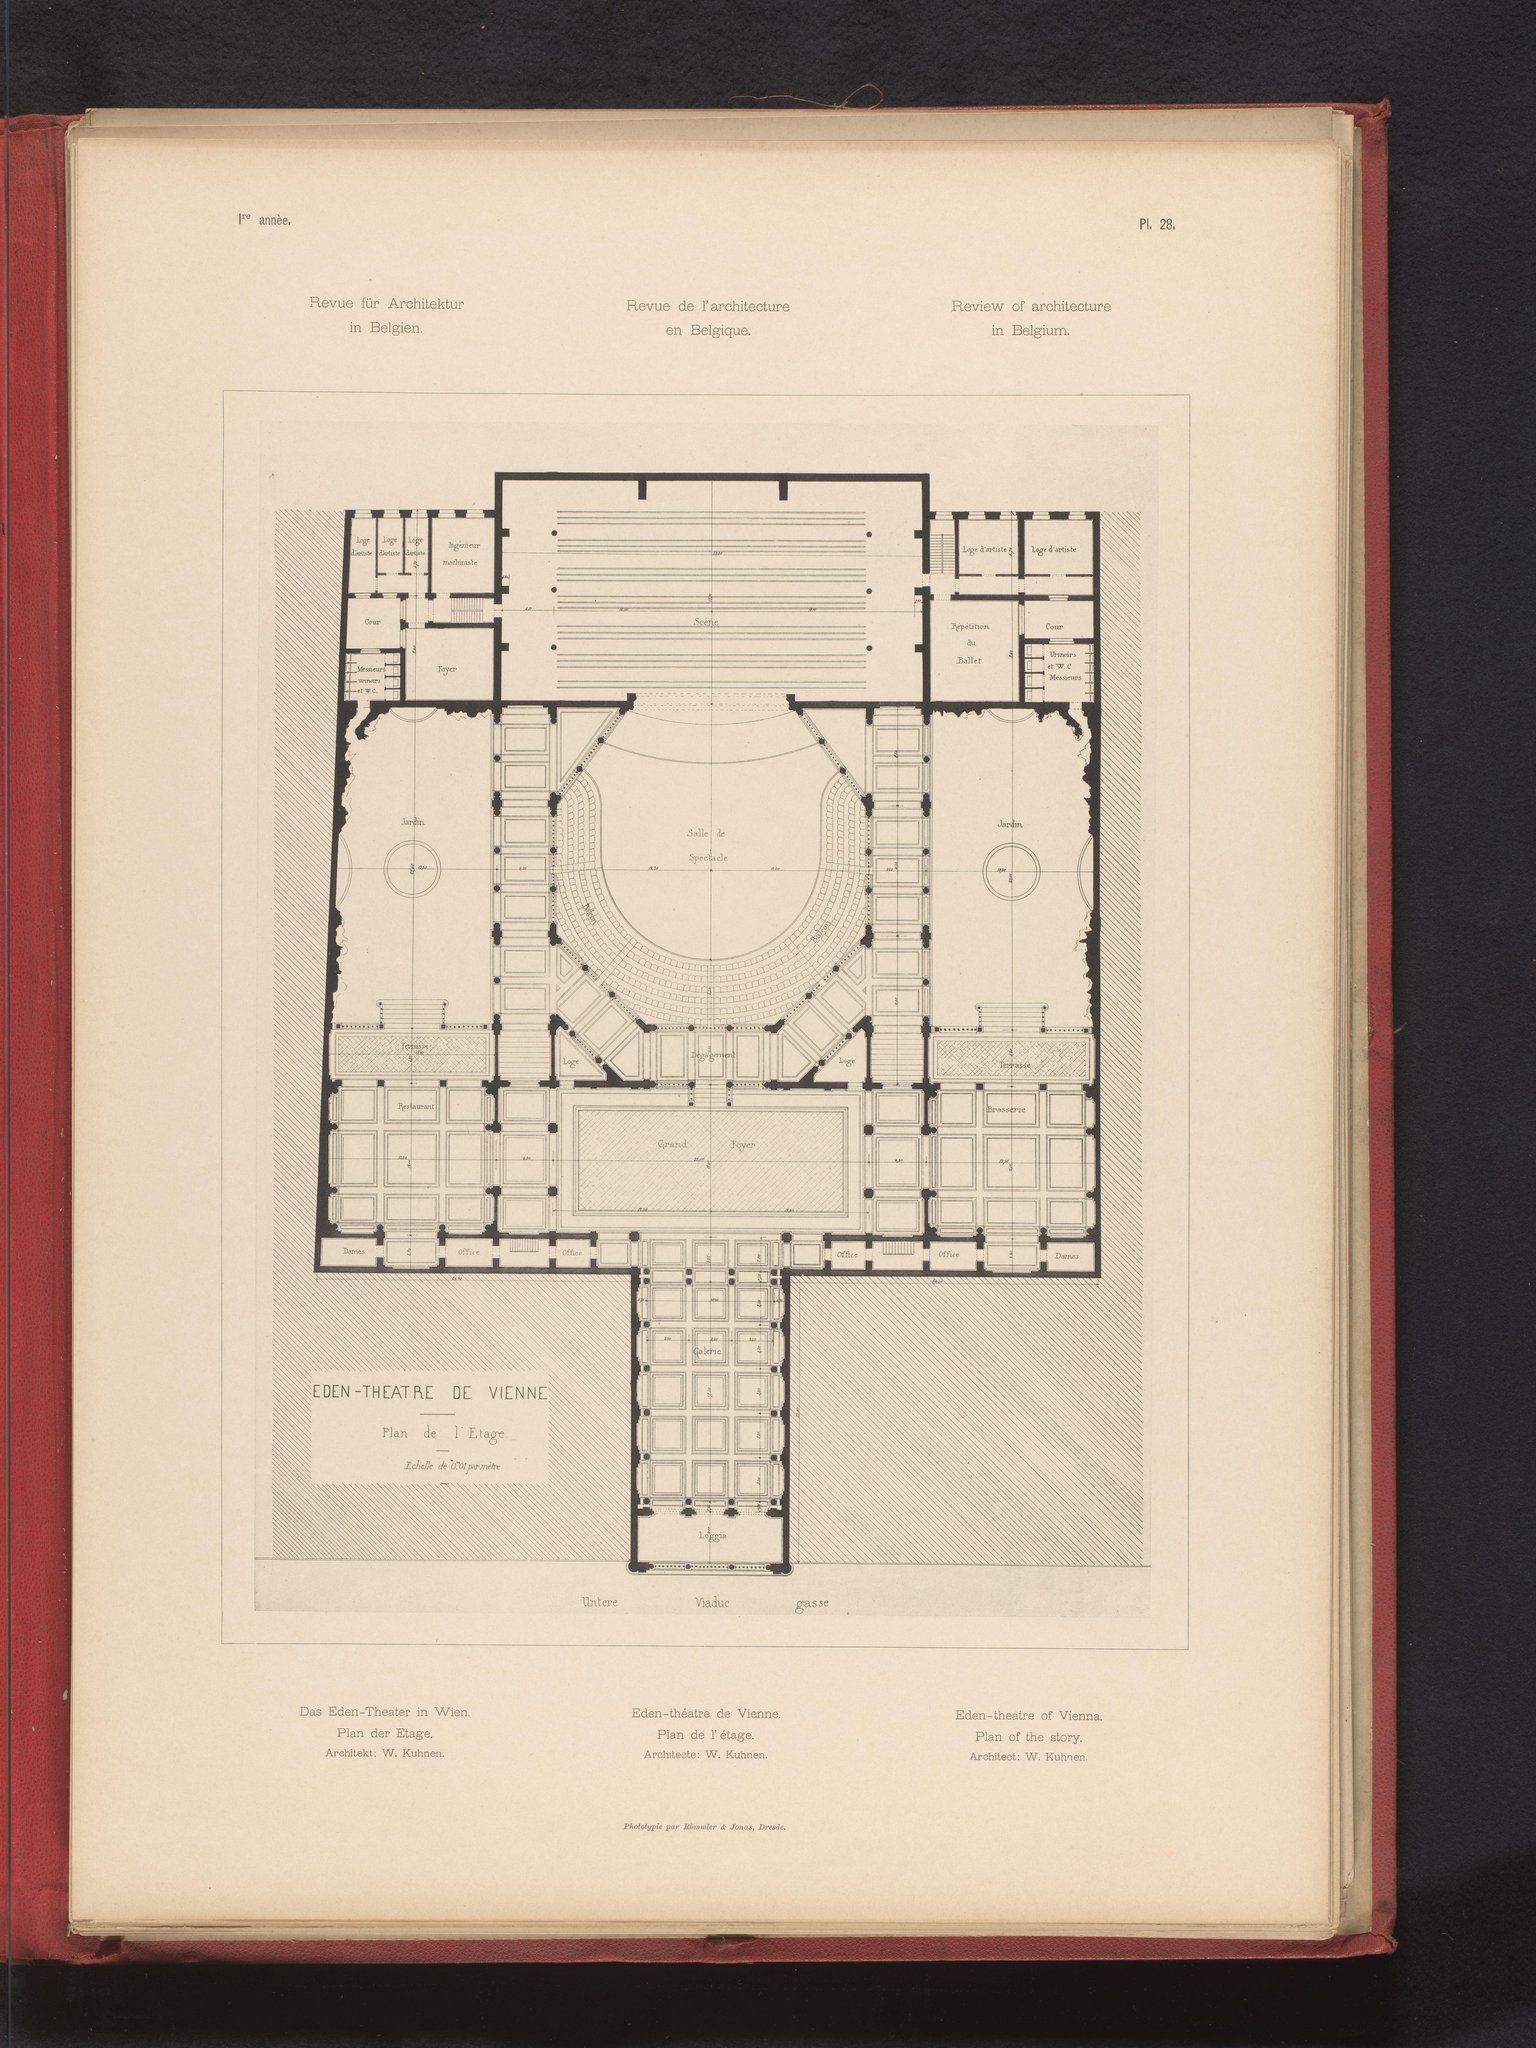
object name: photomechanical print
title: Revue für Architektur in Belgien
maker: w. kuhnen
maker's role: architect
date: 1888-1893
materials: paper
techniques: photograph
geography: dresden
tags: theatre (building), plan ~ architecture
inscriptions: number: ‘Pl. 28.’, inscription: ‘1re. annèe.’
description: Deze prent maakt deel uit van een omslag met 110 prenten op 90 bladen en 18 tekstbladen.